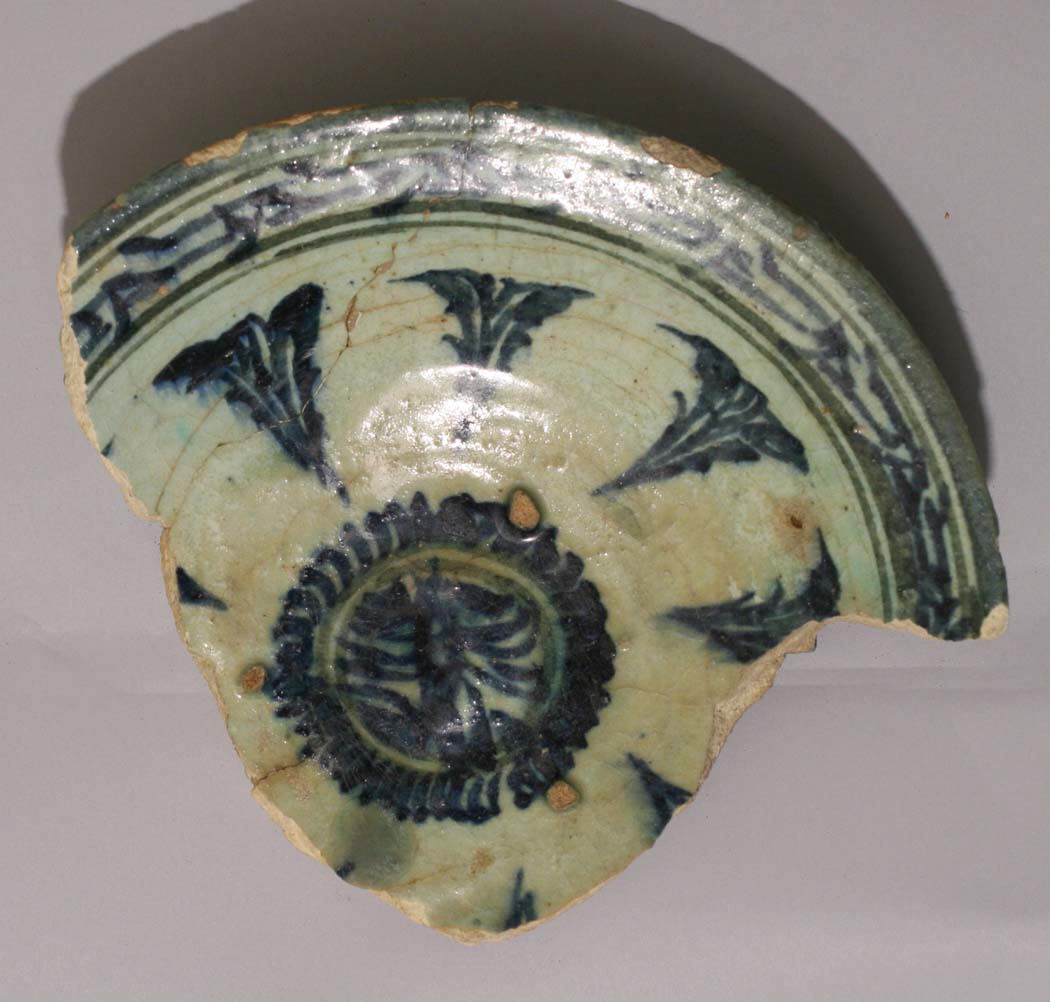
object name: fragment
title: Fragment of a Bowl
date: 1301-1500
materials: glaze, stonepaste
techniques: painting, polychrome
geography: syria